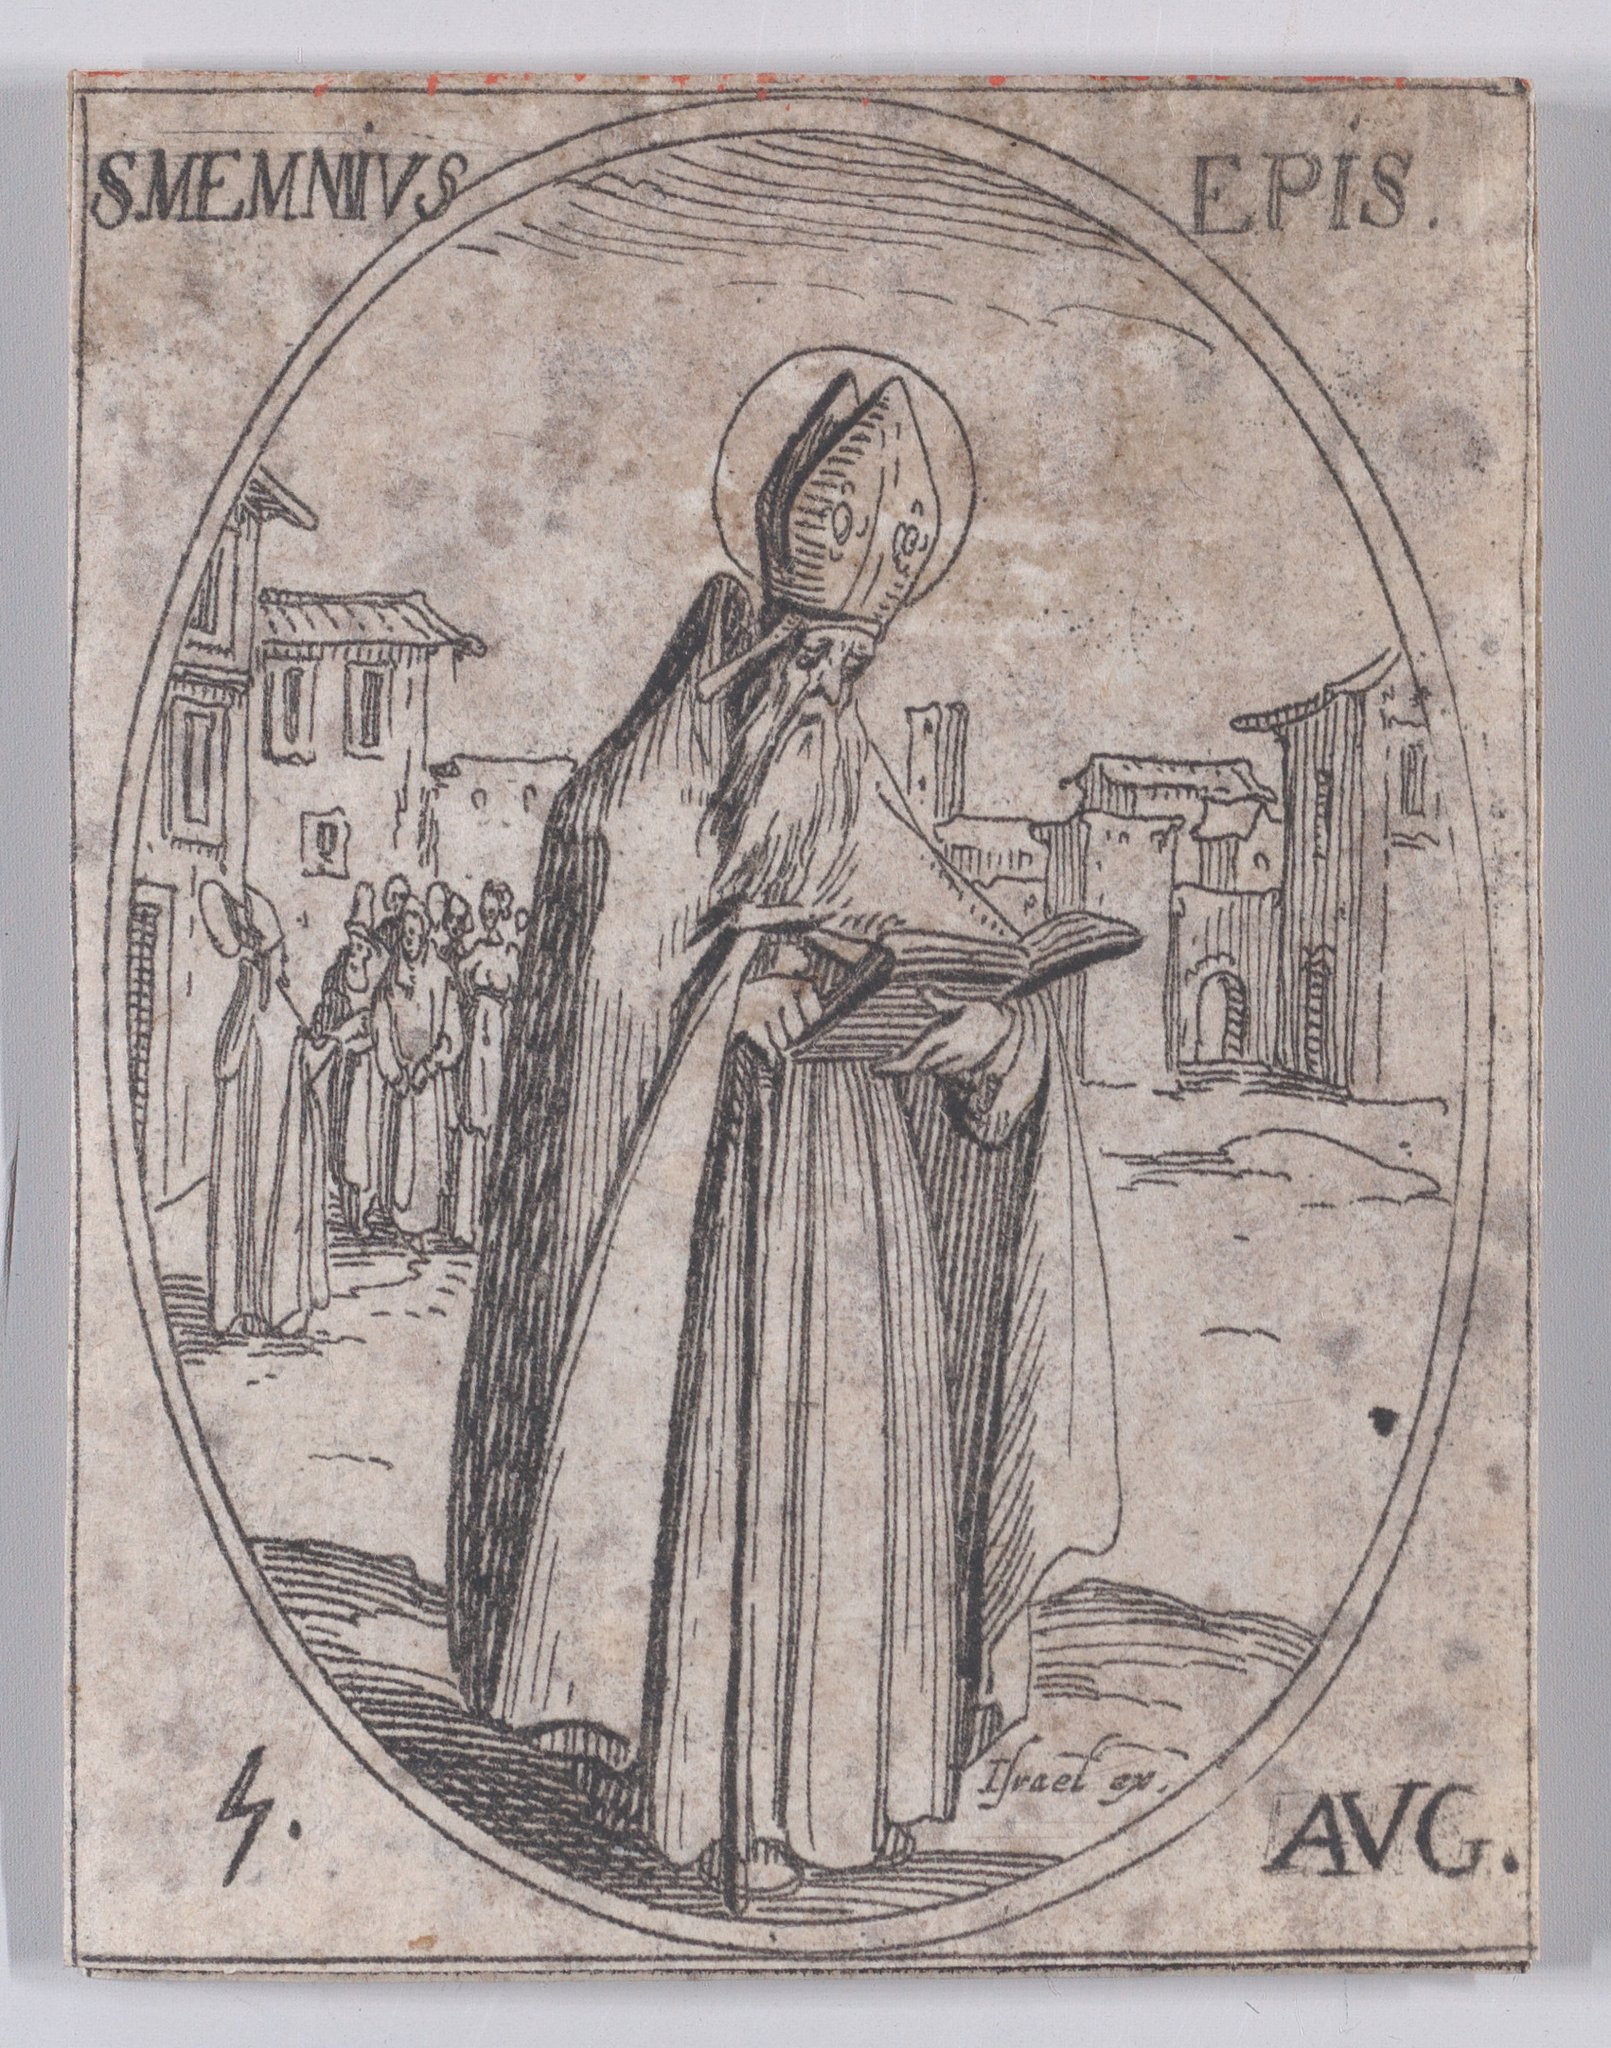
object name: print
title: S. Memmie, évêque (St. Memmius, Bishop), August 5th, from "Les Images De Tous Les Saincts et Saintes de L'Année" (Images of All of the Saints and Religious Events of the Year)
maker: jacques callot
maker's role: artist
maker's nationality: french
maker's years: 1592-1635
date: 1636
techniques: etching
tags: men,bishops,saints